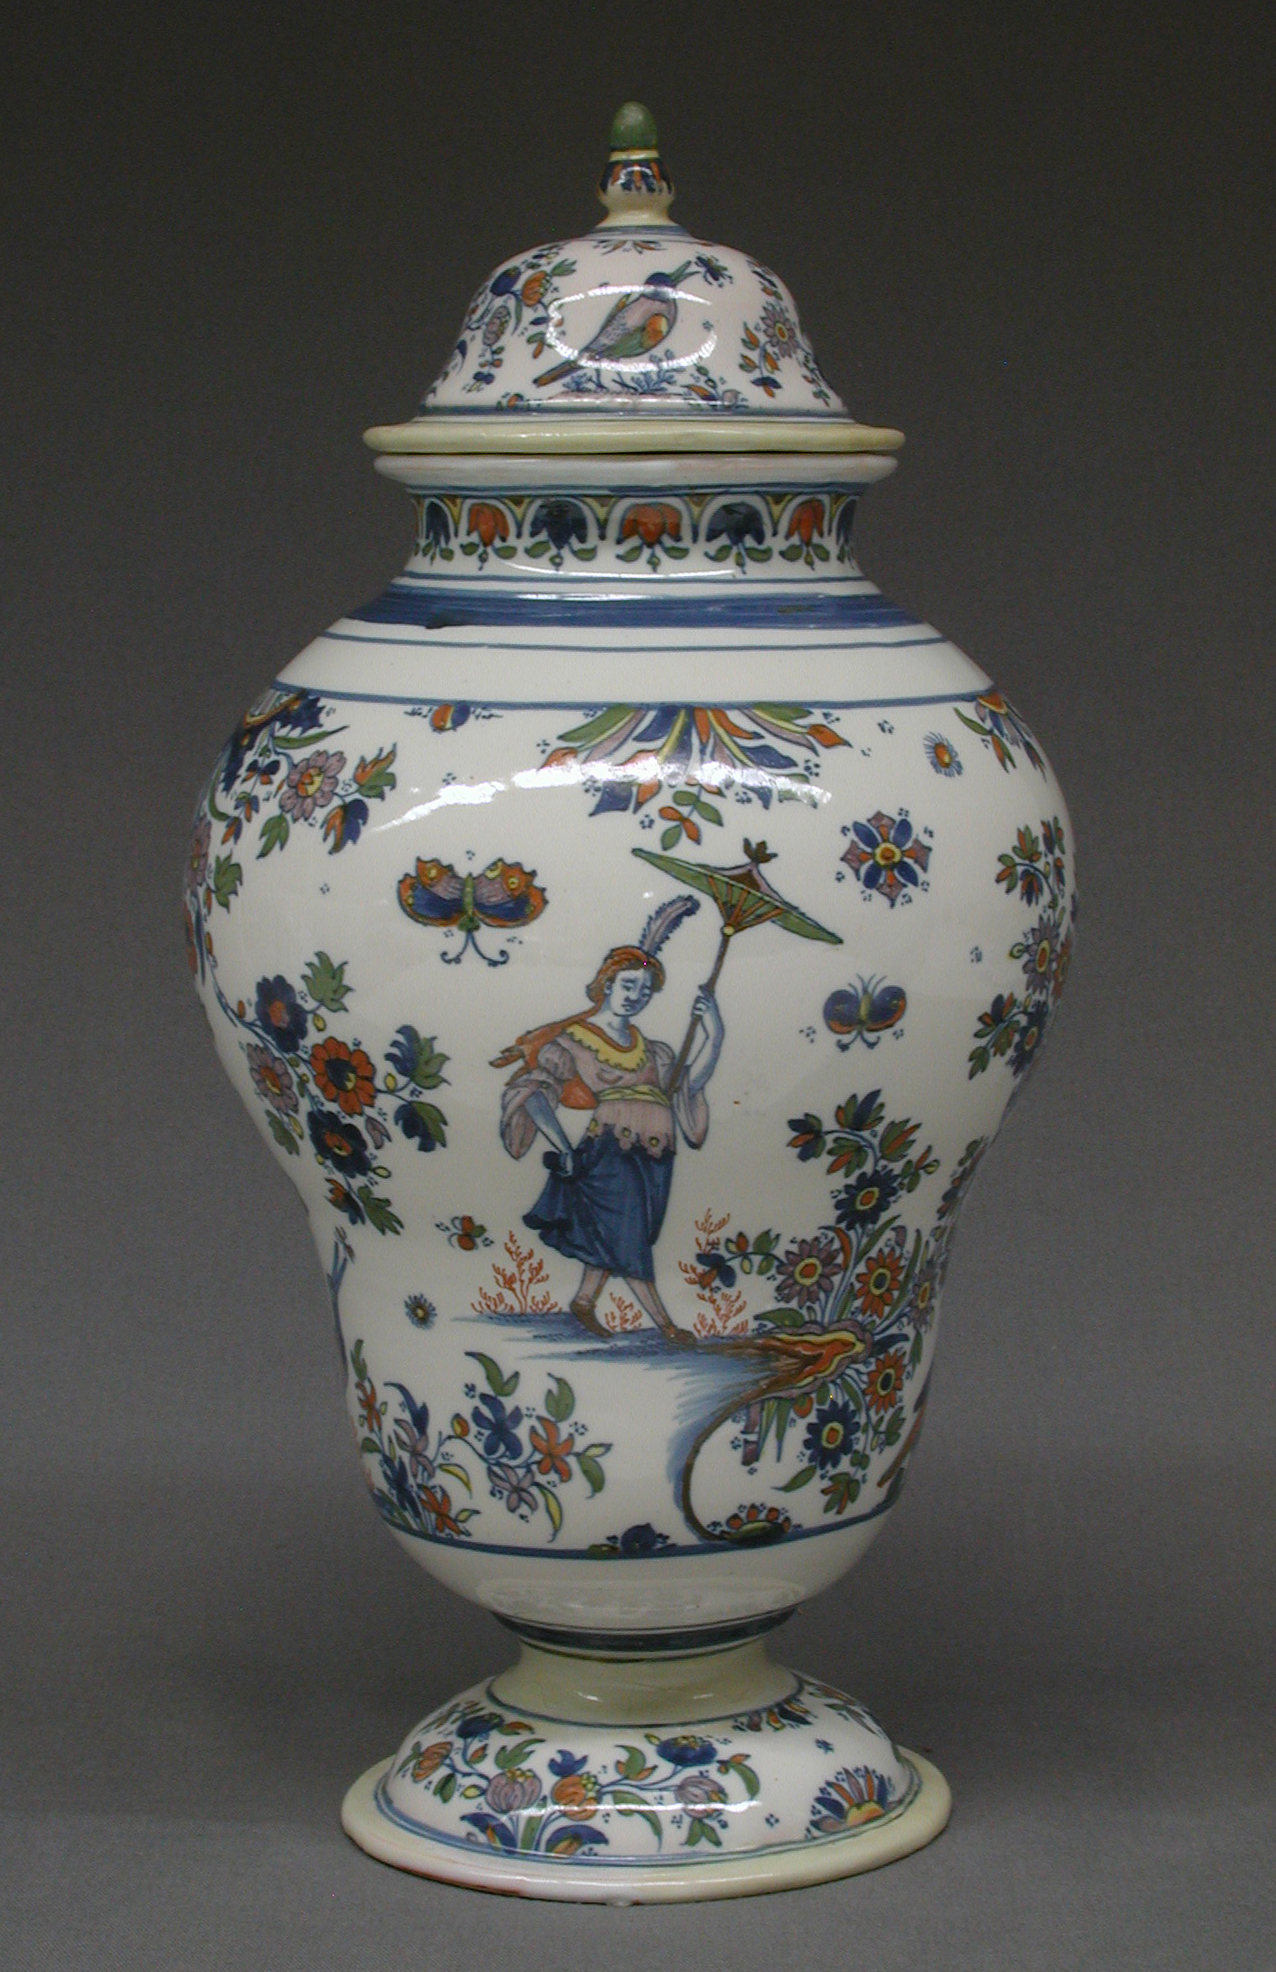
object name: vase with cover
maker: alcora manufactory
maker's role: factory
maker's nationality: spanish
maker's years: 1727-1895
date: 1730-1740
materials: earthenware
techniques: glazing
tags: women,butterflies,flowers